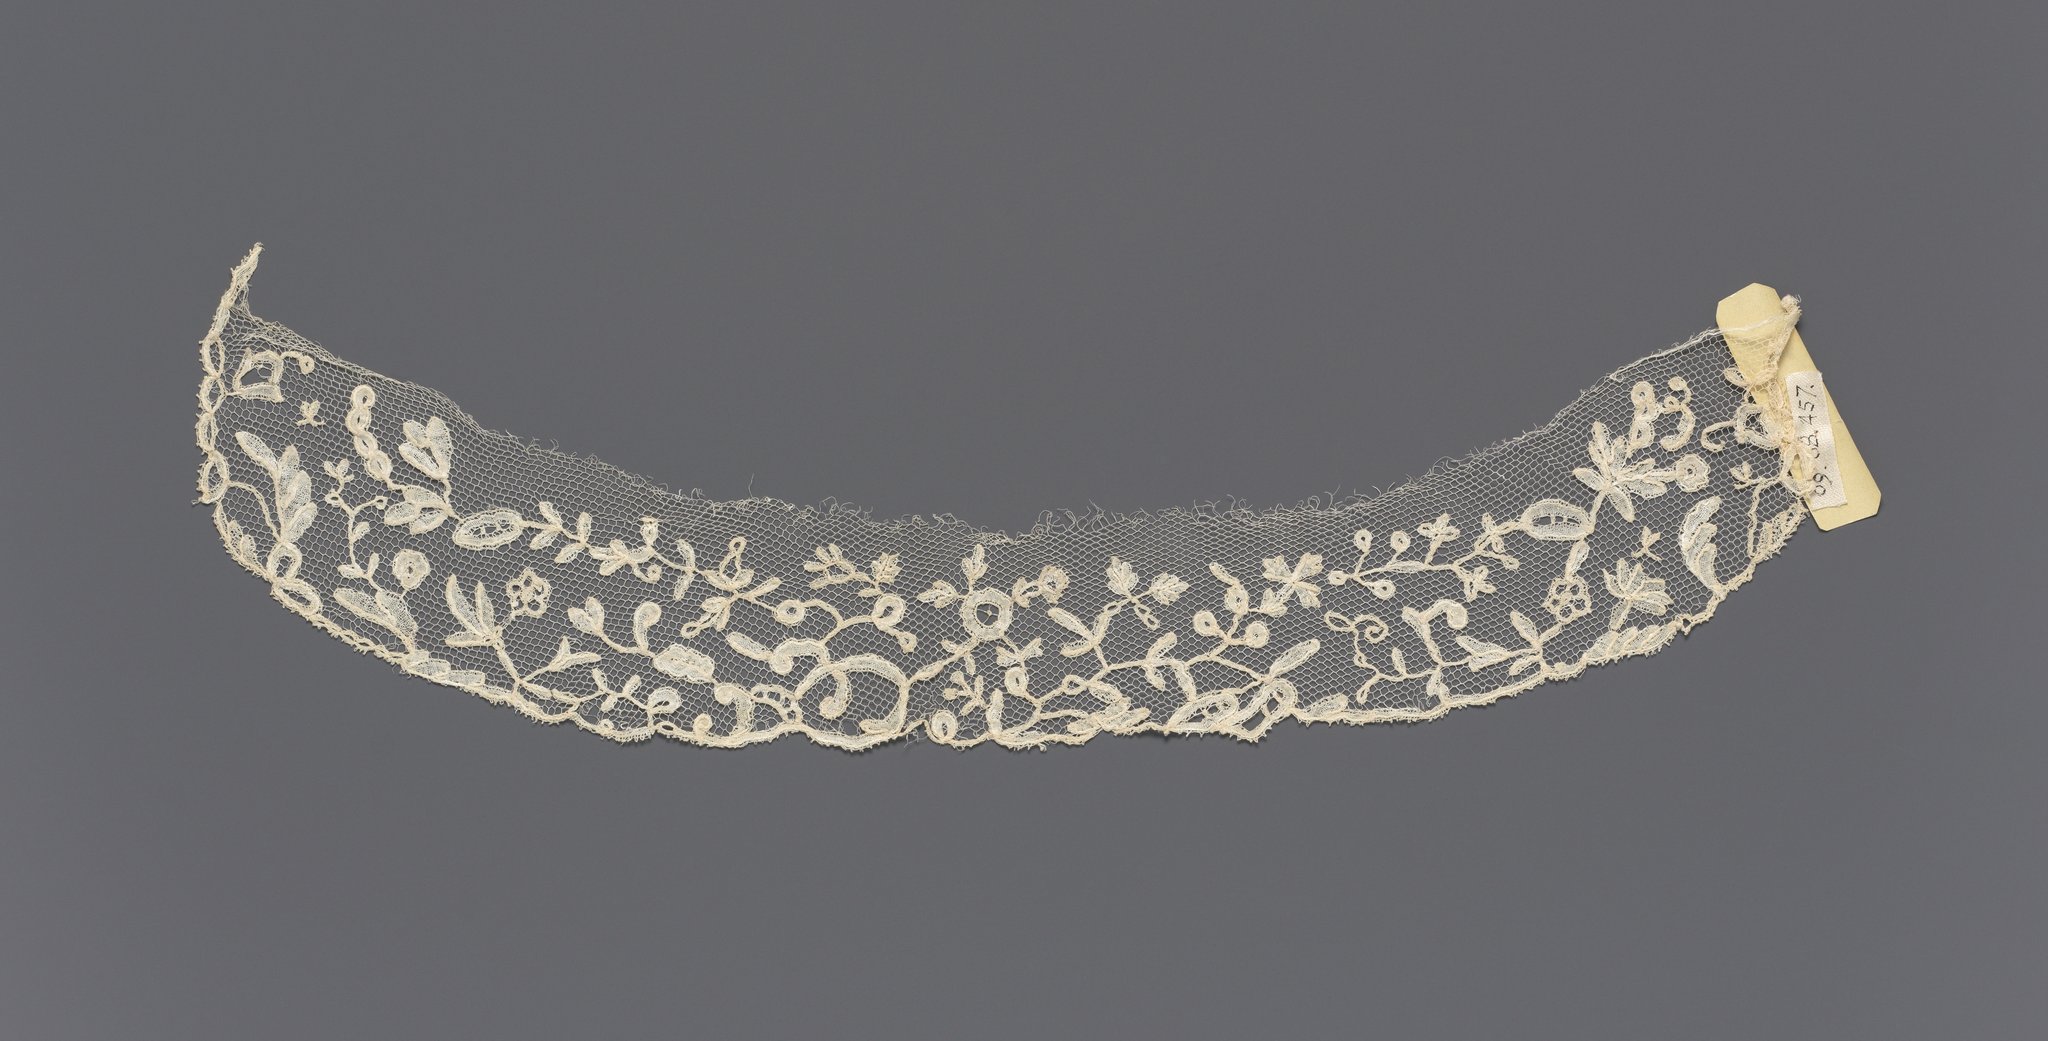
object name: collar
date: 1801-1900